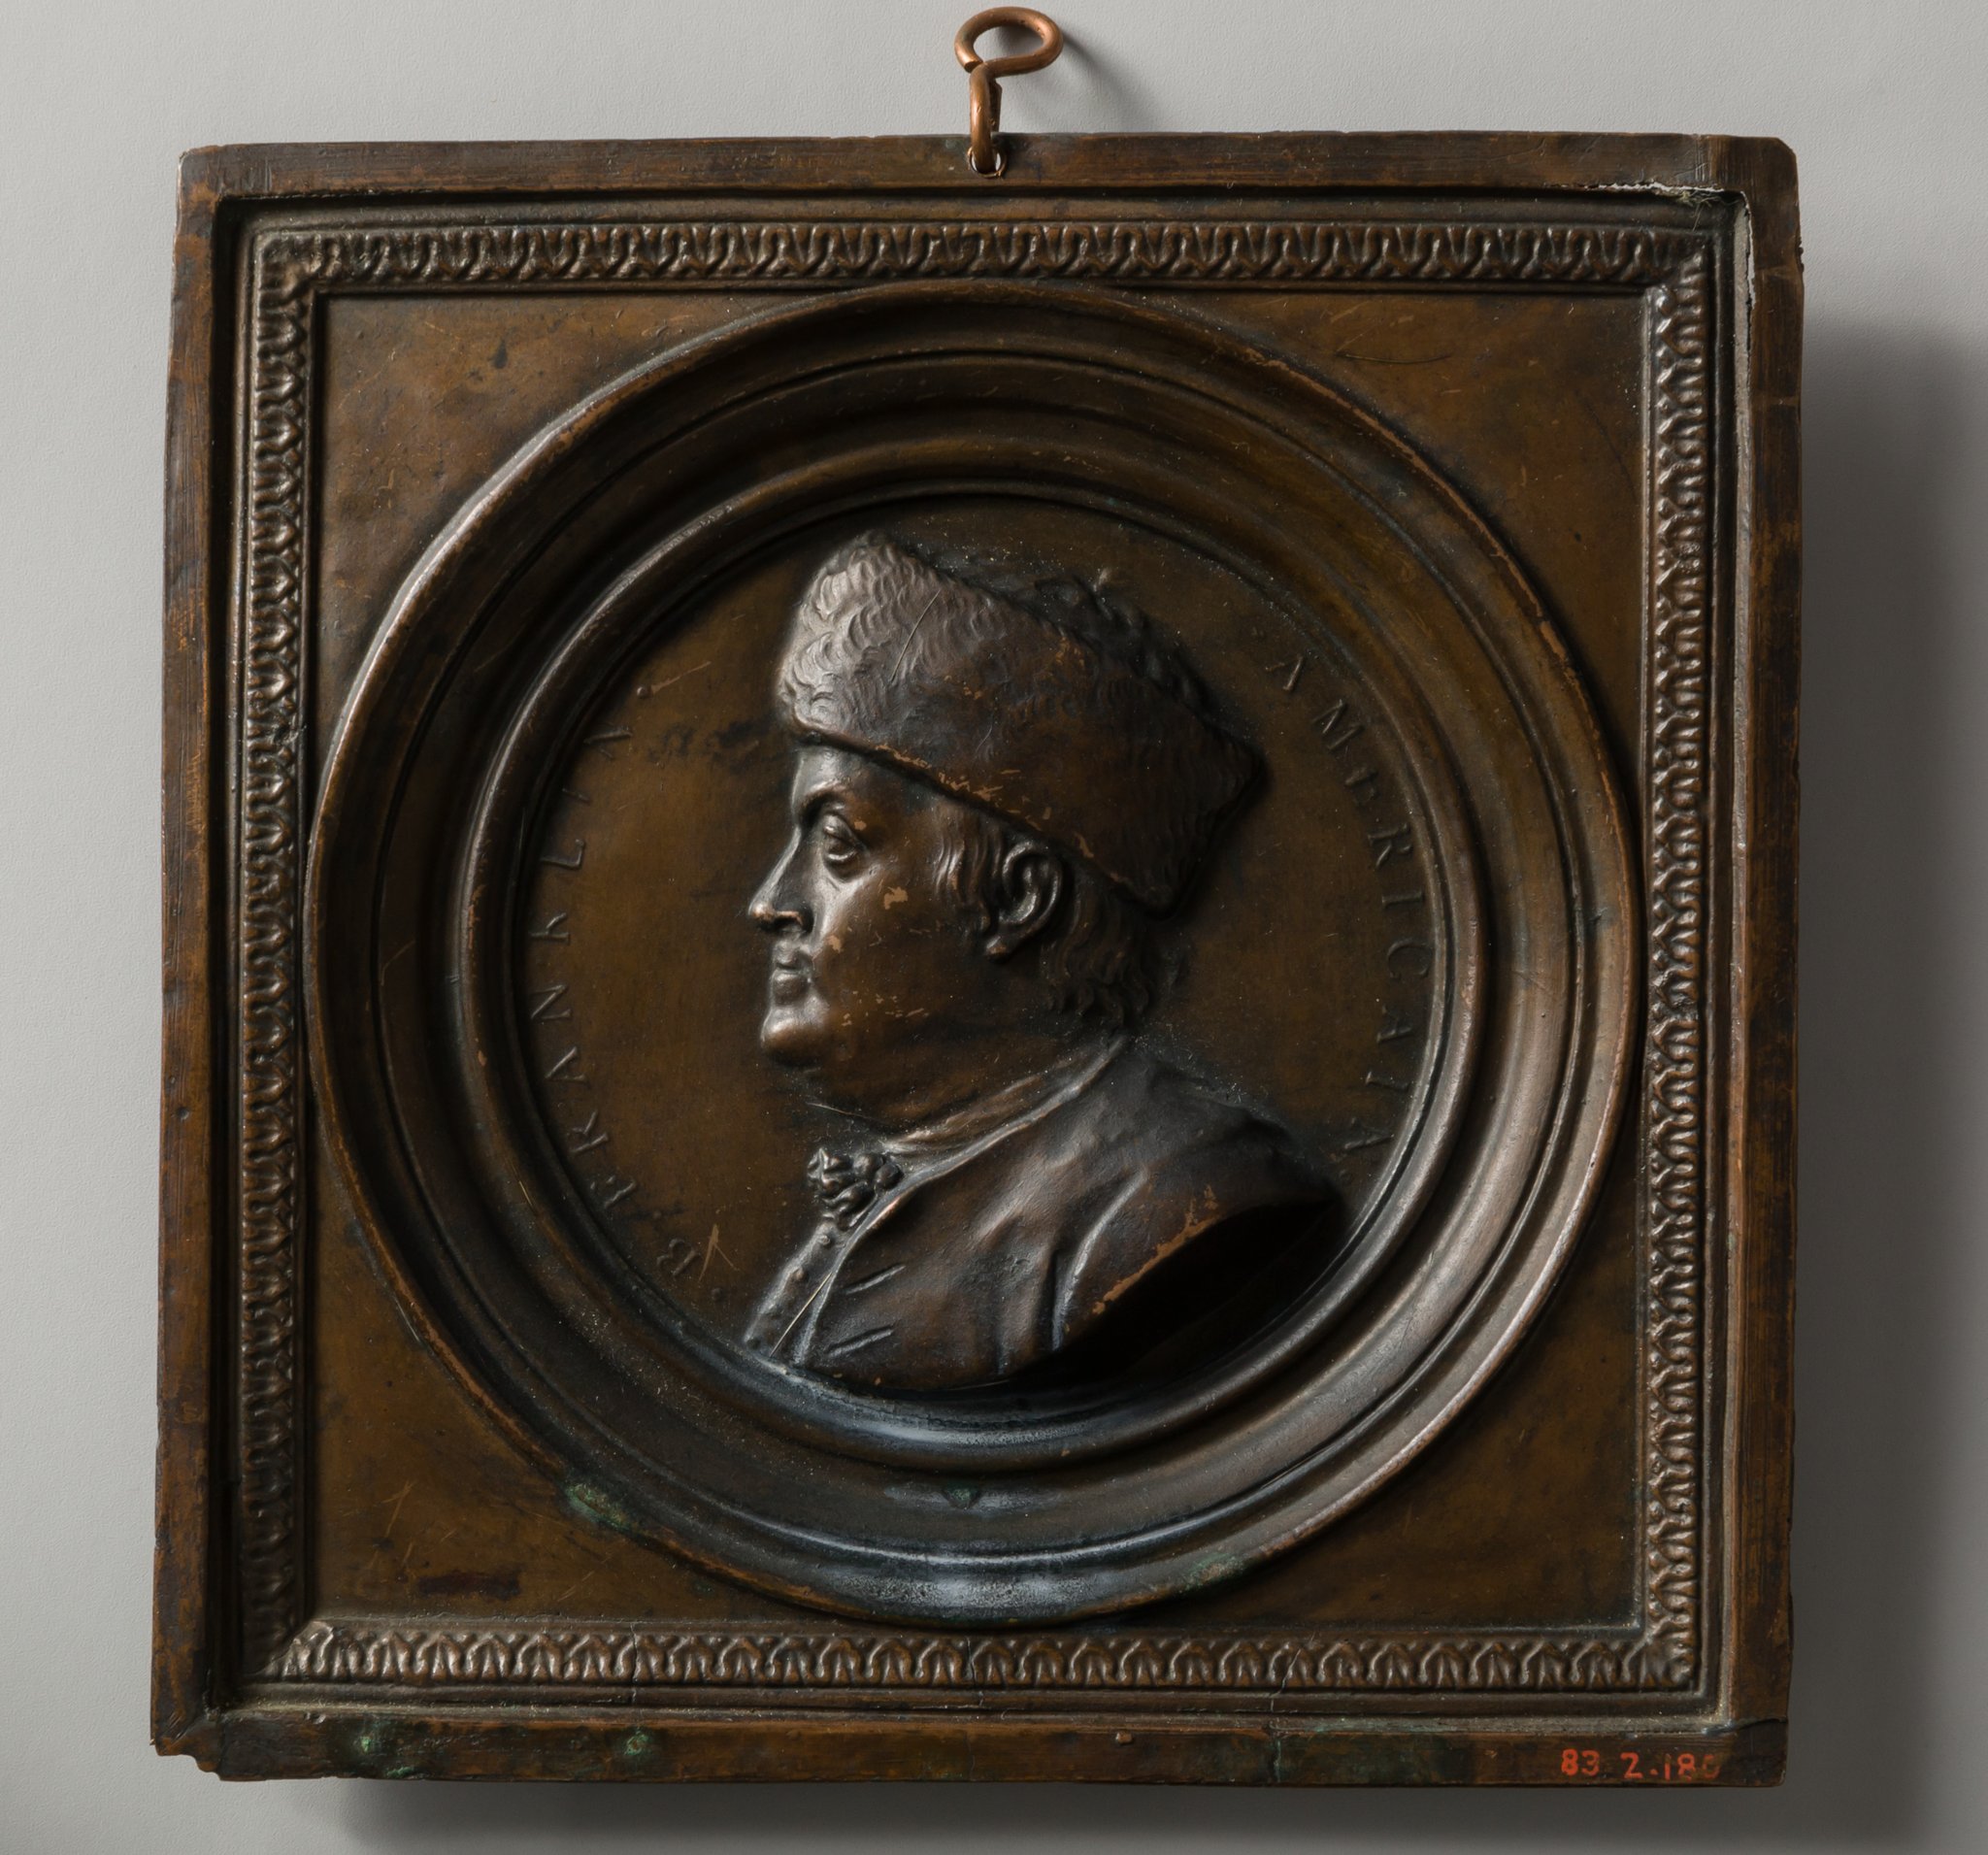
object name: medallion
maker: jean-baptiste nini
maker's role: maker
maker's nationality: italian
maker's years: 1717-1786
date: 1870-1900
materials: copper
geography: france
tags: men,portraits,profiles